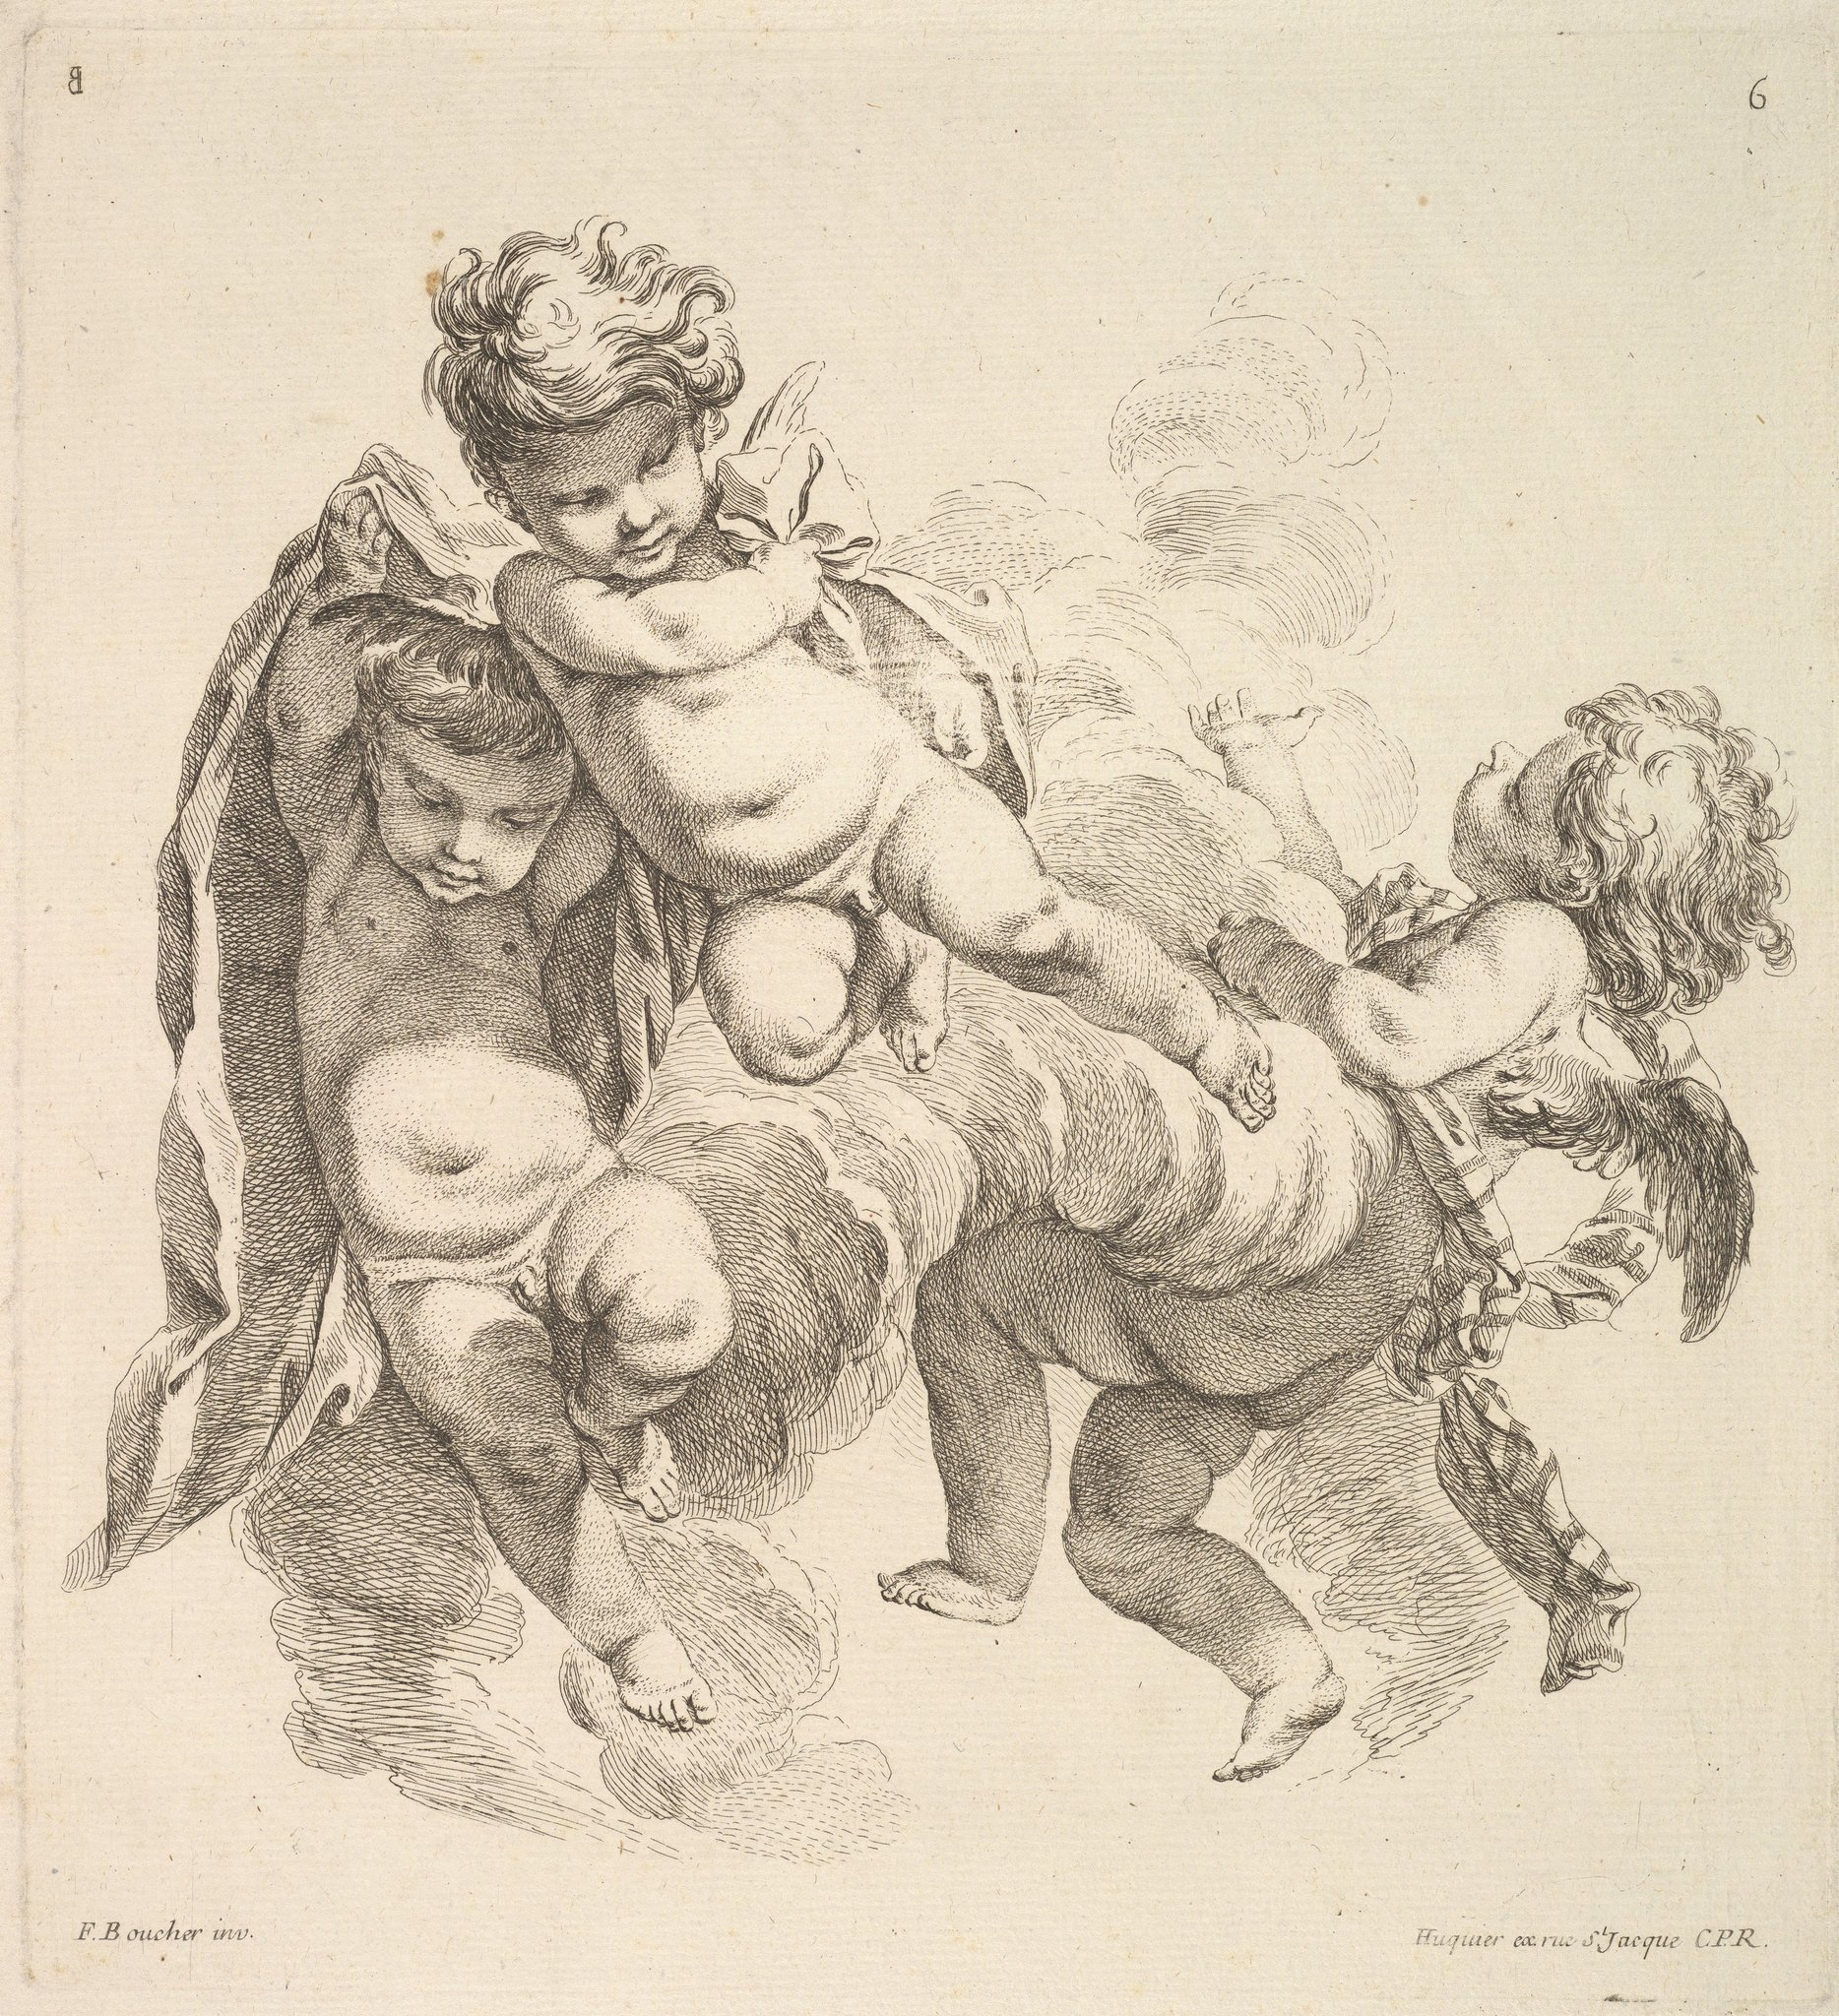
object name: print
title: Three Children Among Clouds Carrying a Drapery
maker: gabriel huquier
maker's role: artist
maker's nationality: french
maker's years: 1695-1772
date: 1738-1745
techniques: engraving, etching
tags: children